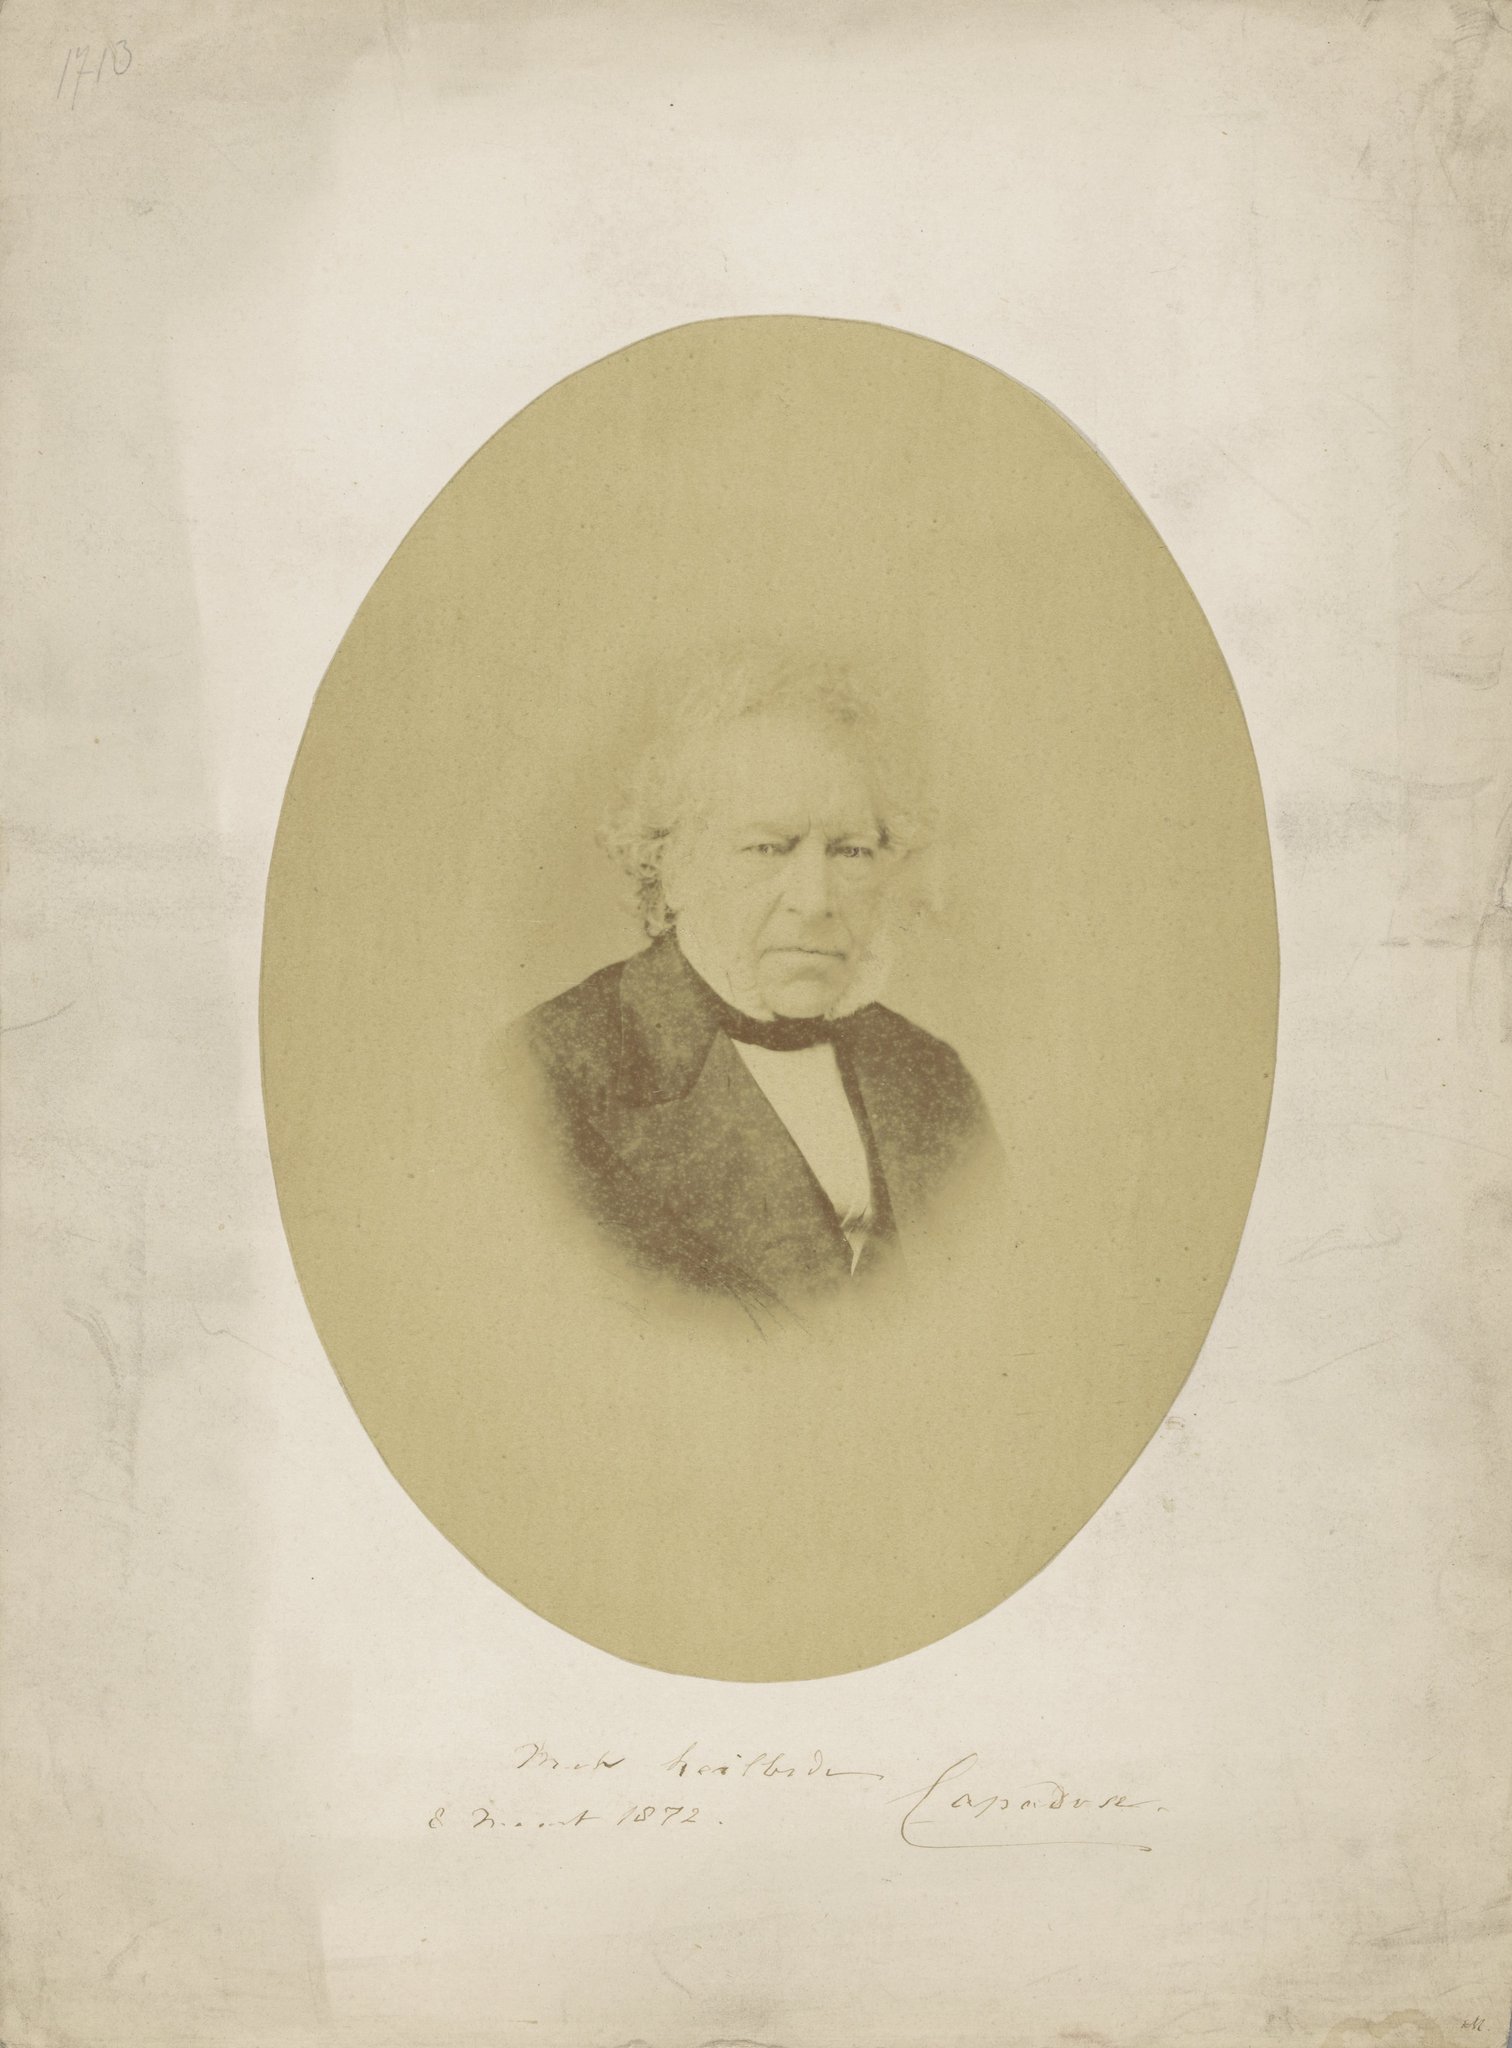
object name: photograph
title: Portret van Abraham Capadose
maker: Anonymous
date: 1872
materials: cardboard, paper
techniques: albumen print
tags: amsterdam, the hague, historical persons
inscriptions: caption: ‘Met heilbode/ 8 maart 1872/ Capadose’